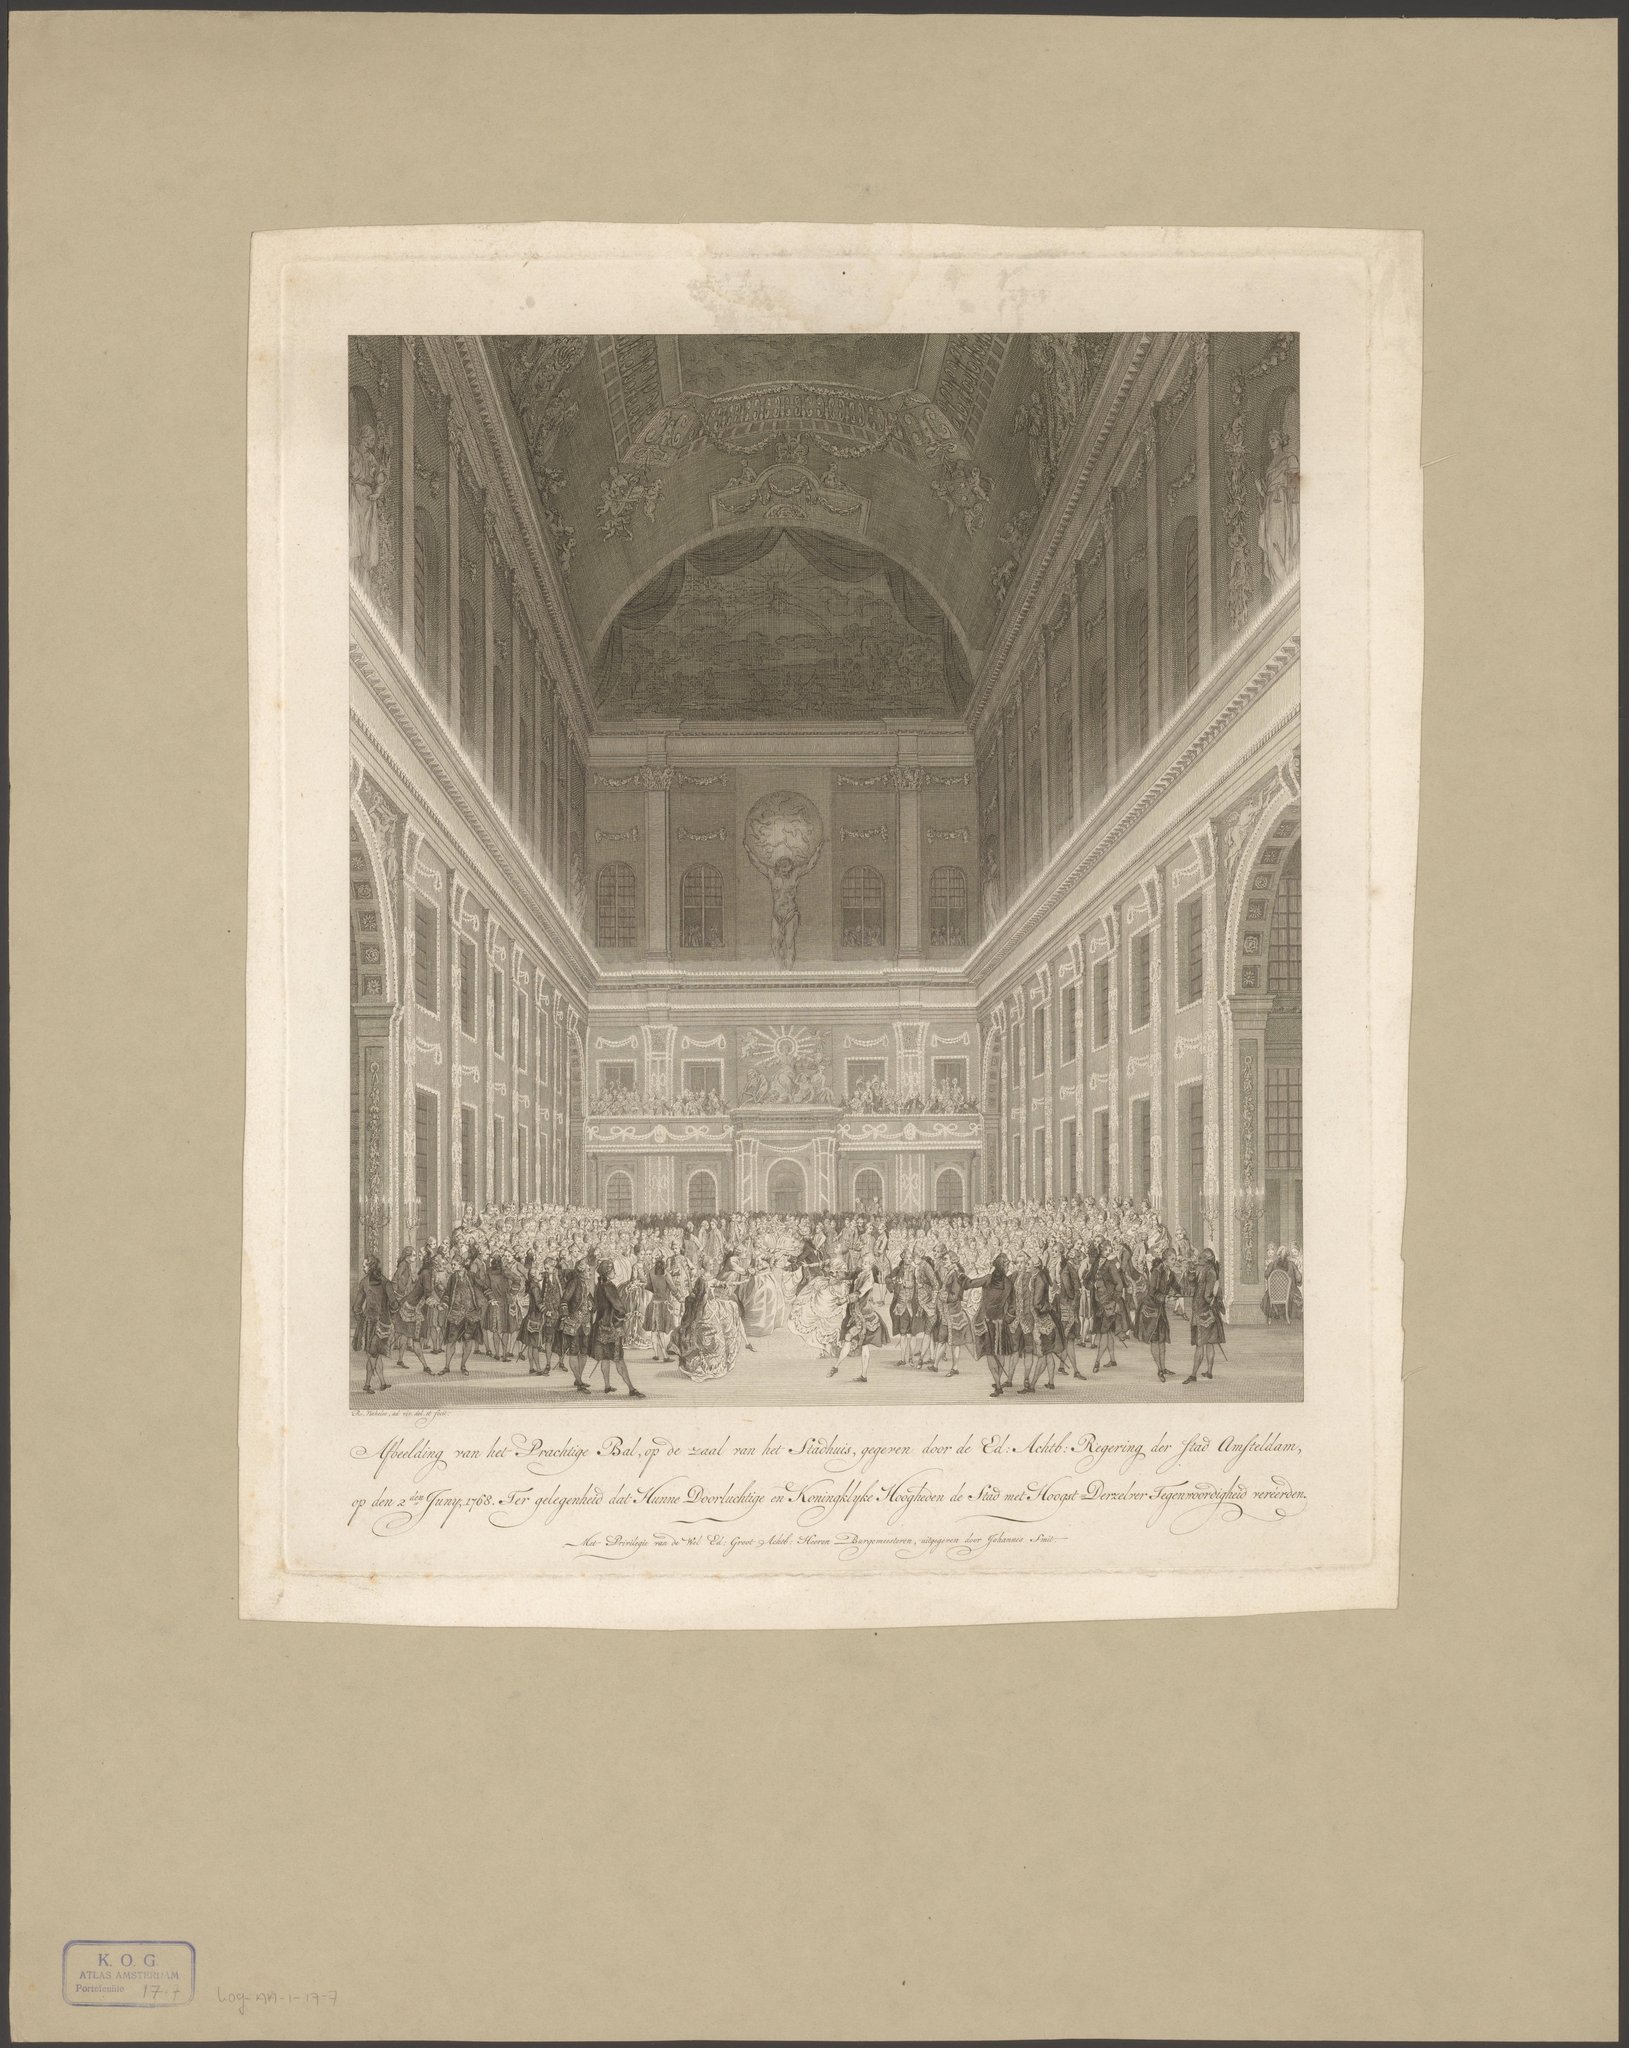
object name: print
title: Afbeelding van het prachtige bal, op de zaal van het Stadhuis, gegeven door de ed: achtb: Regering der stad Amsterdam, op den 2den juny, 1768 (...)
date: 1772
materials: paper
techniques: engraving, etching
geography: amsterdam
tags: the hague, william v (prince of orange), berlin, painter, wilhelmina of prussia (princess of orange), public festivities on the occasion of royal events (+ dancing ~ festive activities), ball, formal dance, townhall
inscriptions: collector's mark: ‘17.7’ Lugt 1641b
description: Onderwerpsrubriek binnen de Atlas Amsterdam: Nieuwe Stadhuis, van binnen: Groote zaal, Raadkamer, Schepenkamer, Troonzaal, Mozeszaal, Zitkamer.